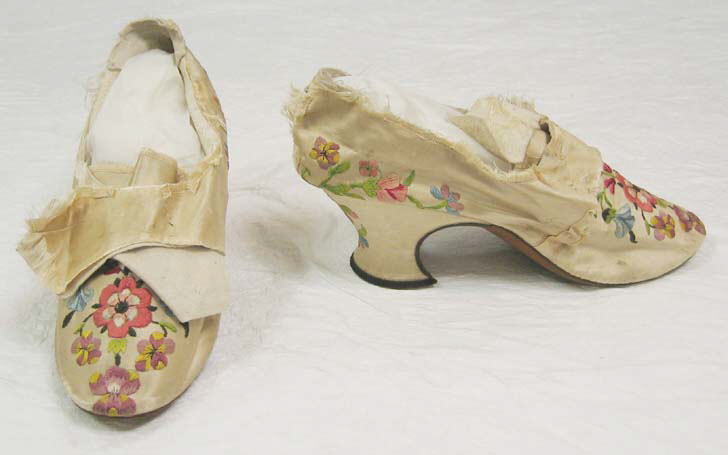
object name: shoe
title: Shoes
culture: british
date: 1701-1800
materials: leather, silk